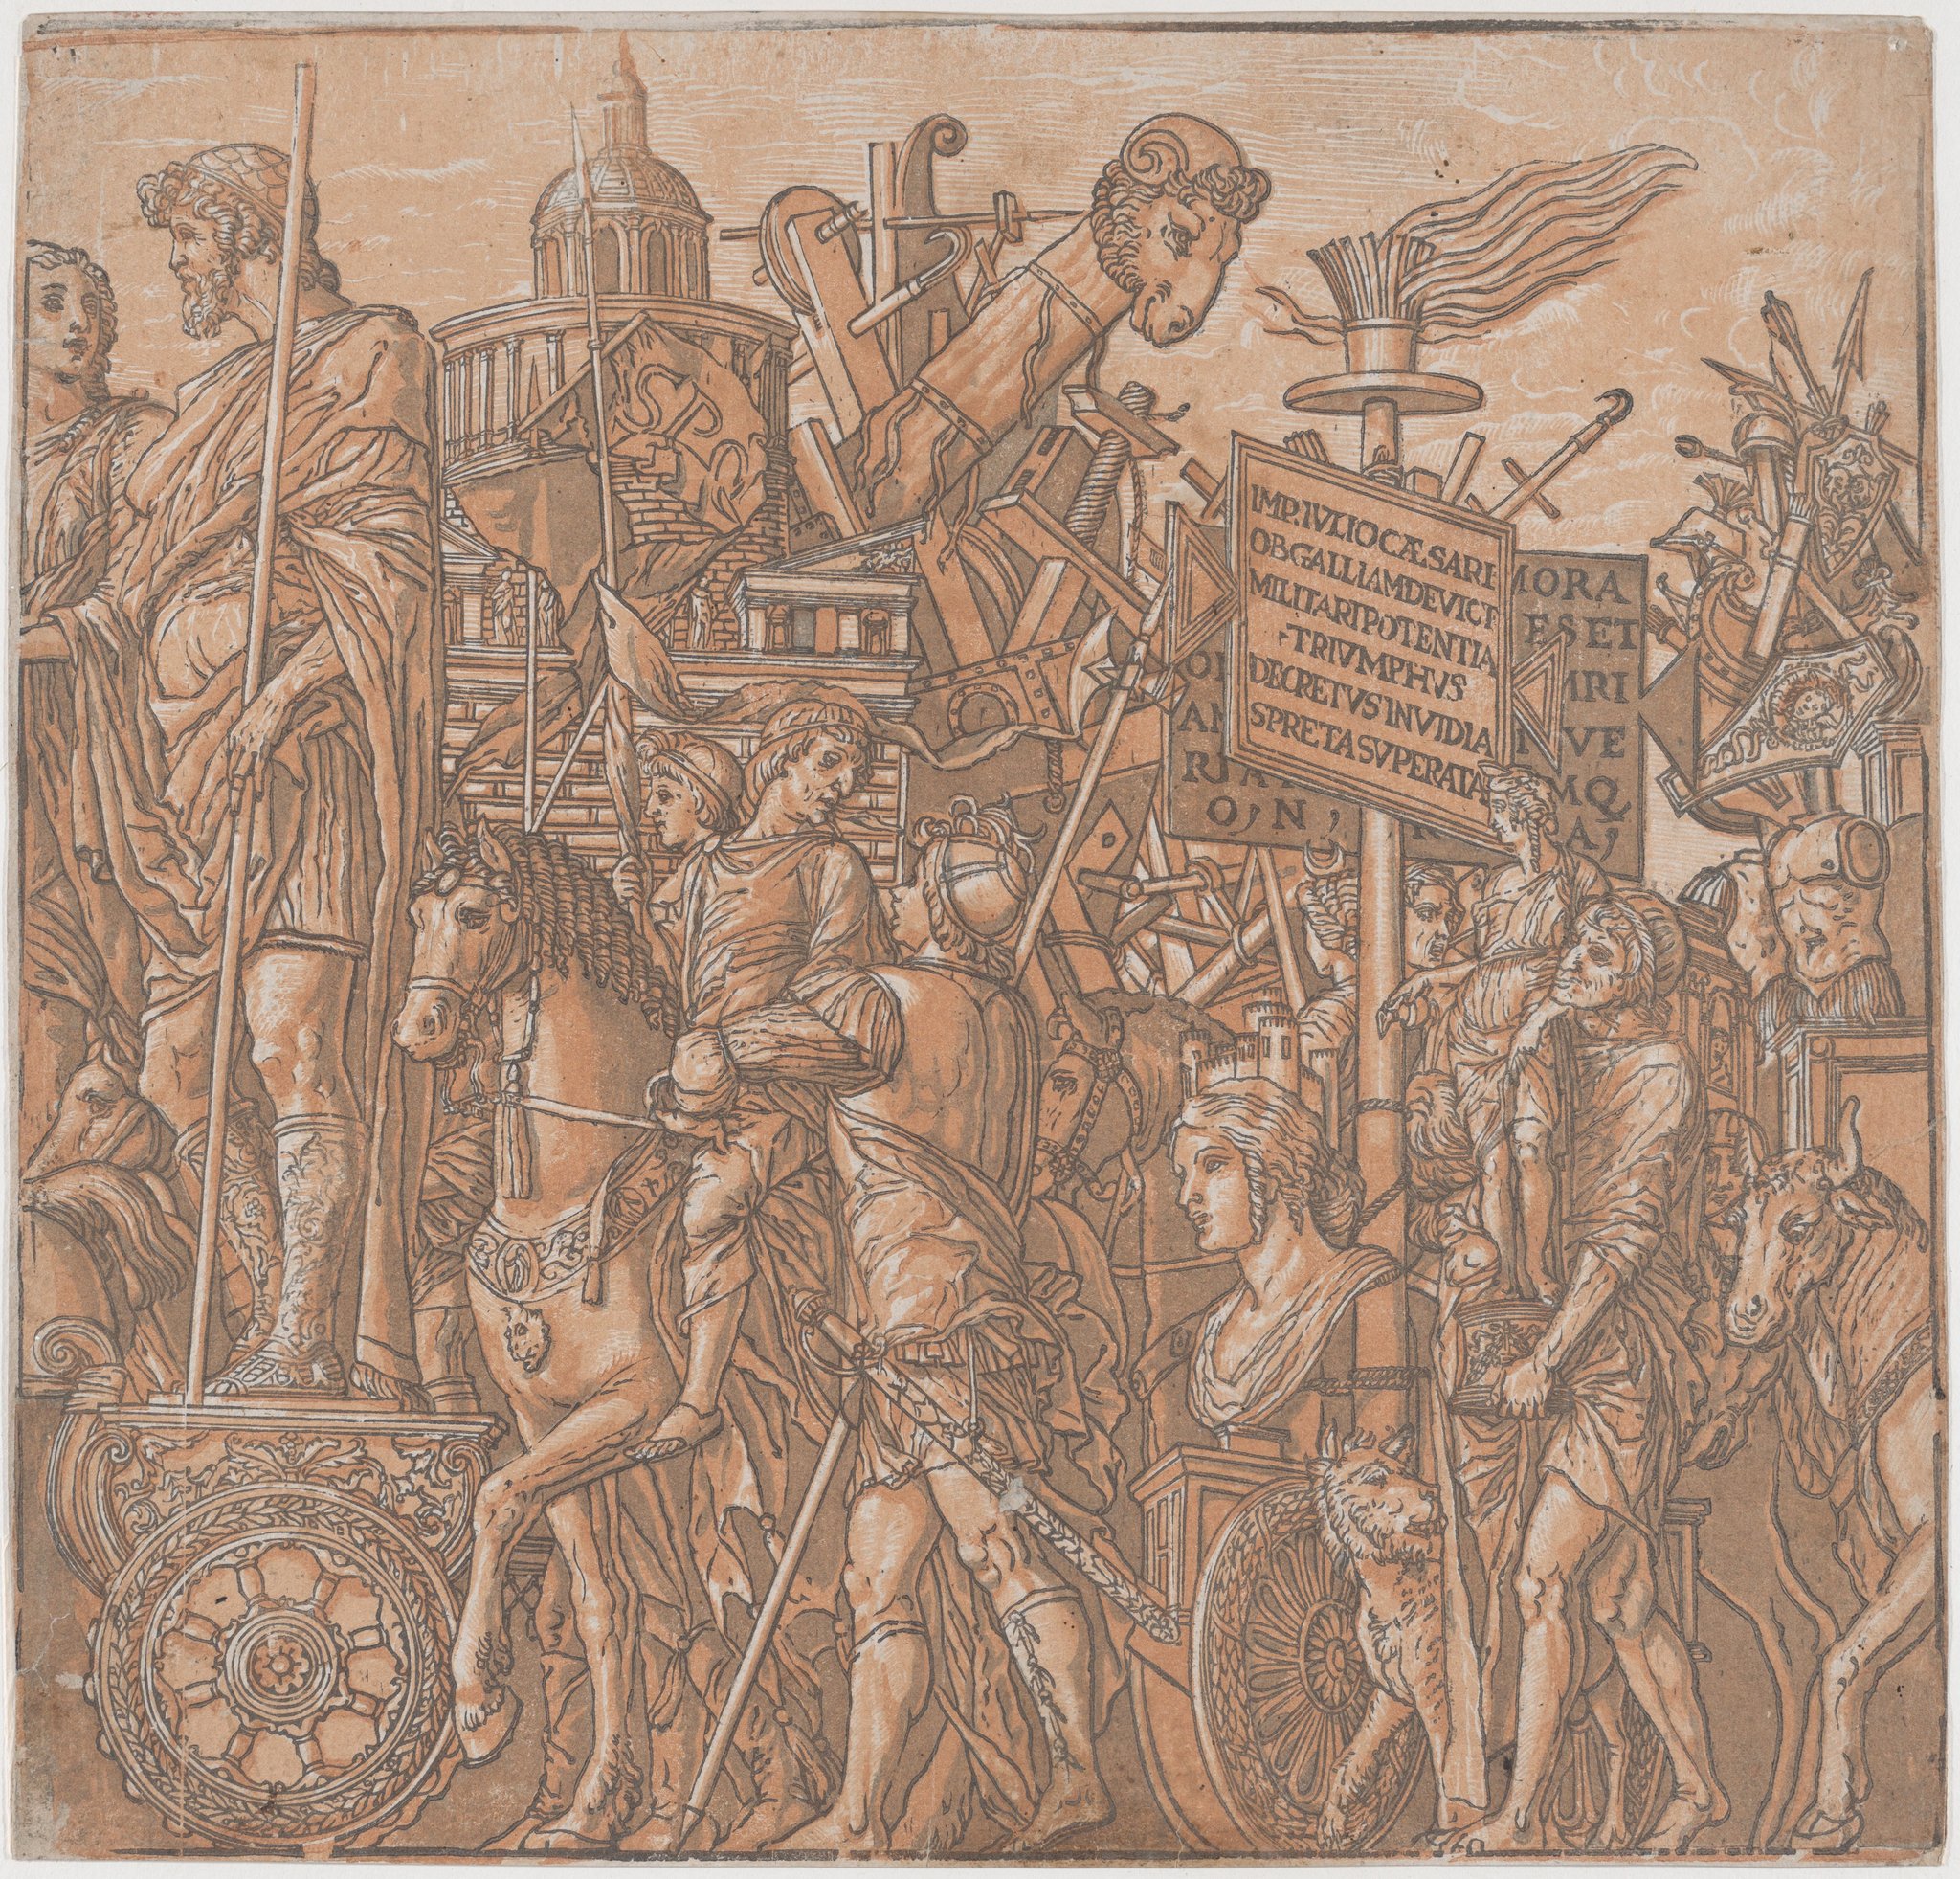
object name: print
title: Sheet 2: A figure on a triumphal chariot surrounded by figures on horseback, from "The Triumph of Julius Caesar"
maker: andrea andreani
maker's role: artist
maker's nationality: italian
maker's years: 1558-1629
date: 1599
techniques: woodcut, printing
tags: julius caesar,men,women,horses,chariots